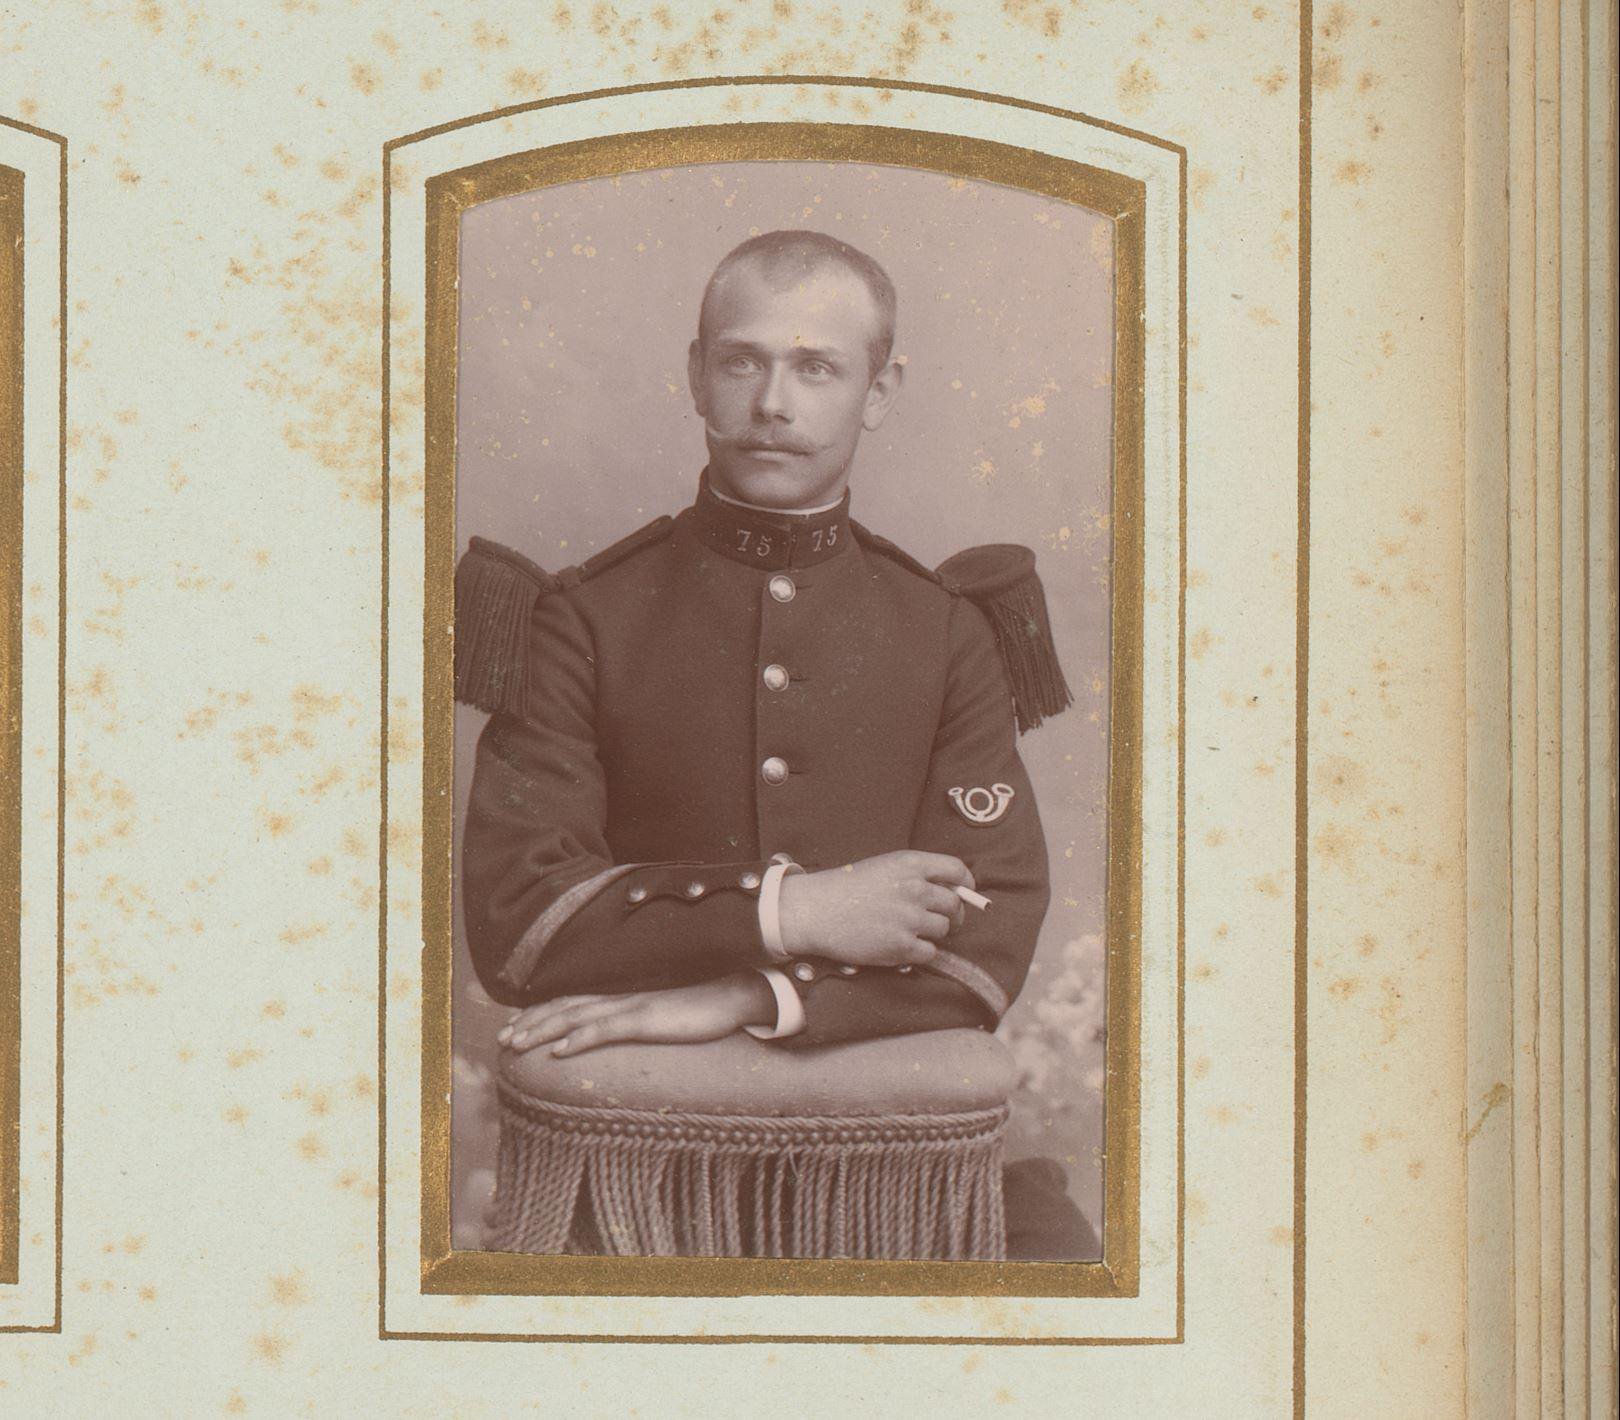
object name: photograph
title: Portret van een man in uniform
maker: Anonymous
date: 1880-1920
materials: cardboard, photographic support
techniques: gelatin silver print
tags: historical persons